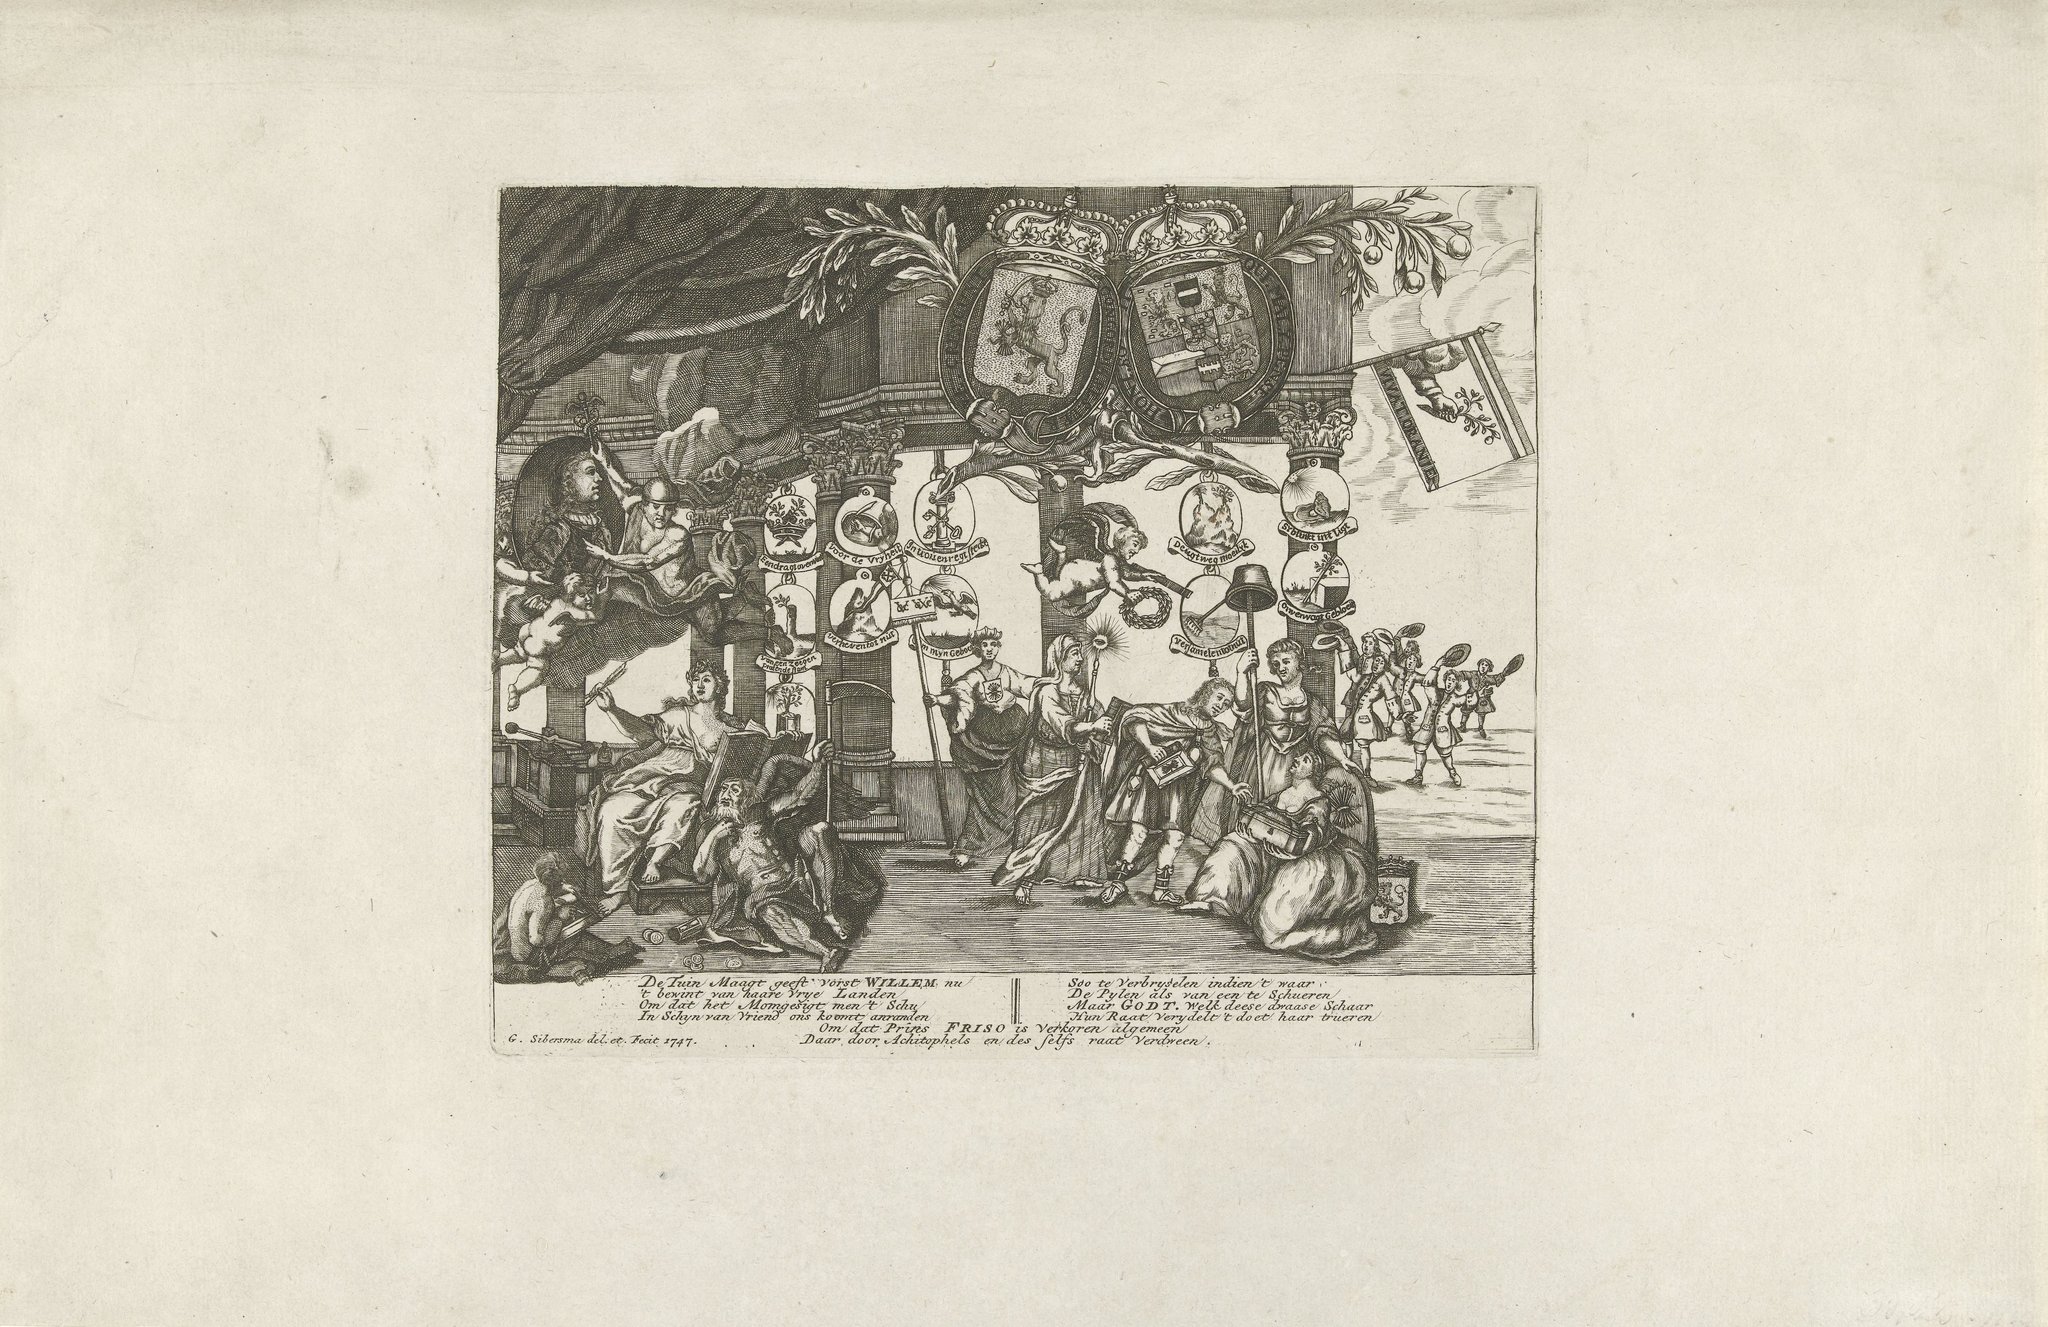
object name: print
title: Allegorie op de verheffing van Willem IV, 1747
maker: gerrit sibersma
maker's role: print maker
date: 1747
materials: paper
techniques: engraving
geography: northern netherlands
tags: the hague, willem iv (prins van oranje-nassau), personifications of countries, nations, states, districts, etc., netherlands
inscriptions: collector's mark: Lugt 2228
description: Allegorie op de verheffing van Willem IV tot stadhouder van de Republiek, mei 1747. De Nederlandse Maagd overhandigt het bewind over de Republiek aan de stadhouder. Links wordt een portret van de stadhouder hoog gehouden door Mercurius en engelen, ten overstaan van de Historie en de Tijd. In de lucht verschillende emblemen en de wapens van de Republiek en van Willem IV. Centraal een personificatie van de Zeevaart met een standaard met de vaandels van de VOC en WIC. In het onderschrift een vers in twee kolommen.